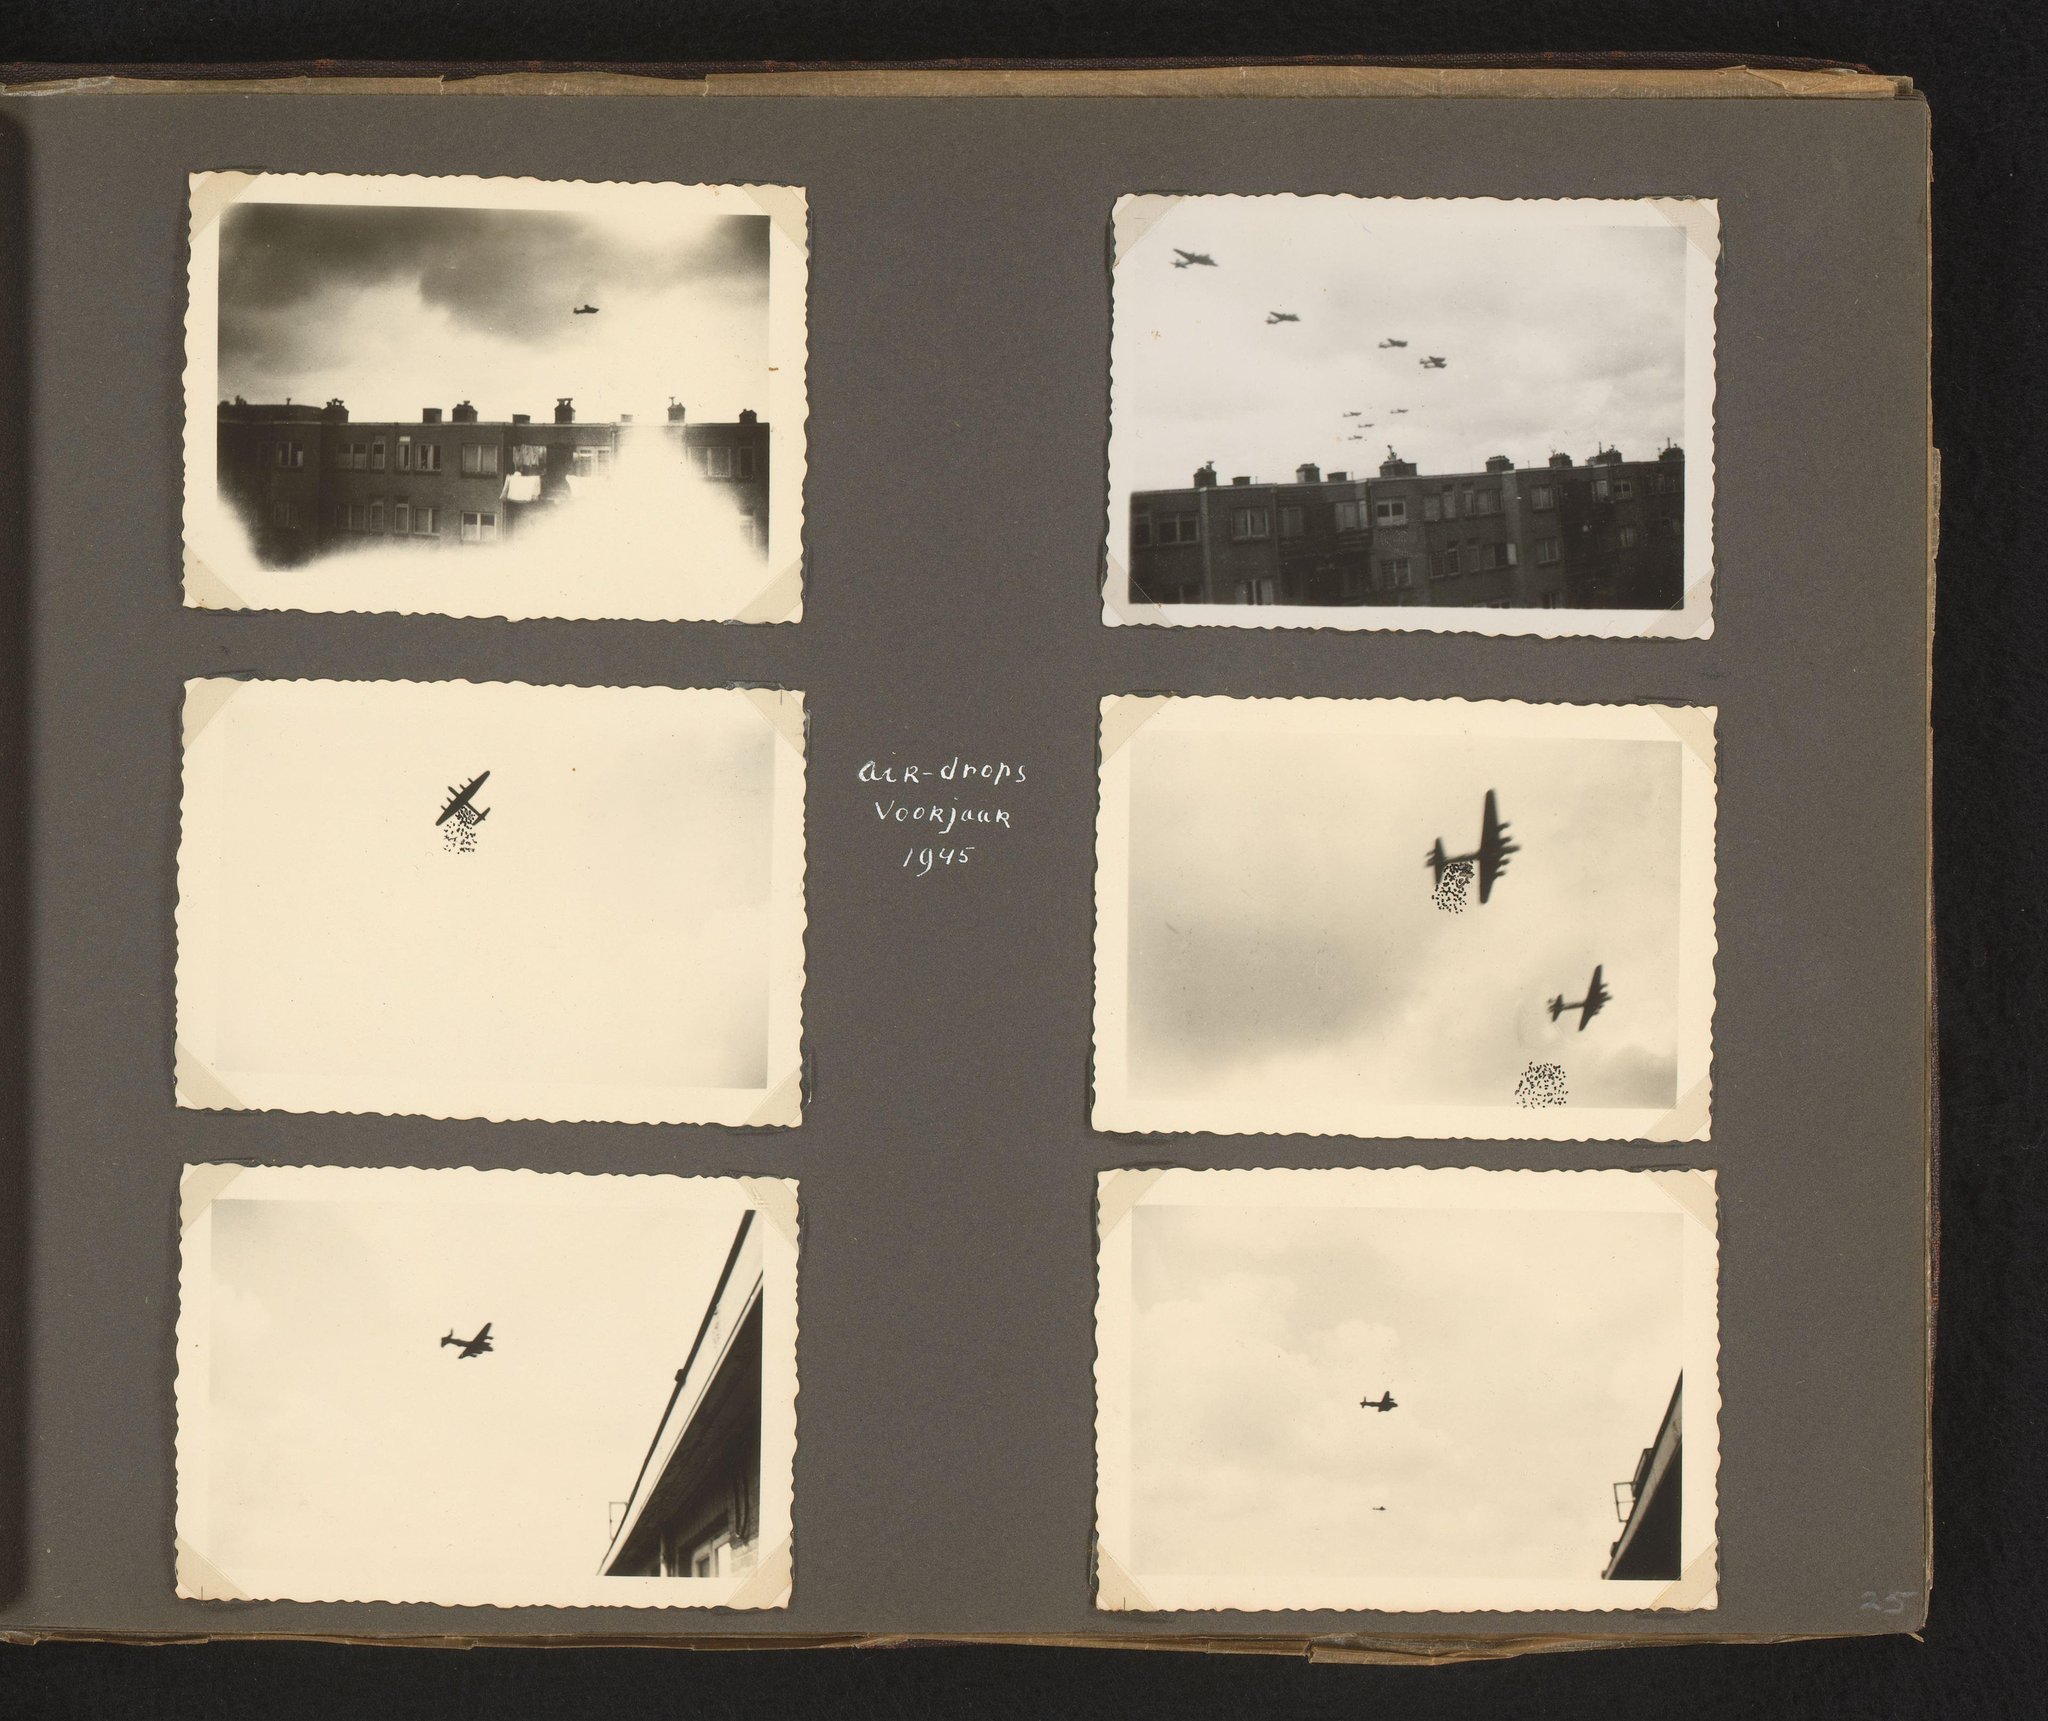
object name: photograph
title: Voedseldroppings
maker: Anonymous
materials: ink, paper, photographic support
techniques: gelatin silver print, pen, retouching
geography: the hague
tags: giving food, aircraft, aeroplane, non-combatants ~ war, the hague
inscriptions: inscription: ‘air-drops voorjaar 1945’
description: Albumblad met zes foto's van voedseldroppings vanuit vliegtuigen in het voorjaar van 1945. Mogelijk te Den Haag. Onderdeel van het Familiealbum 1940-1947